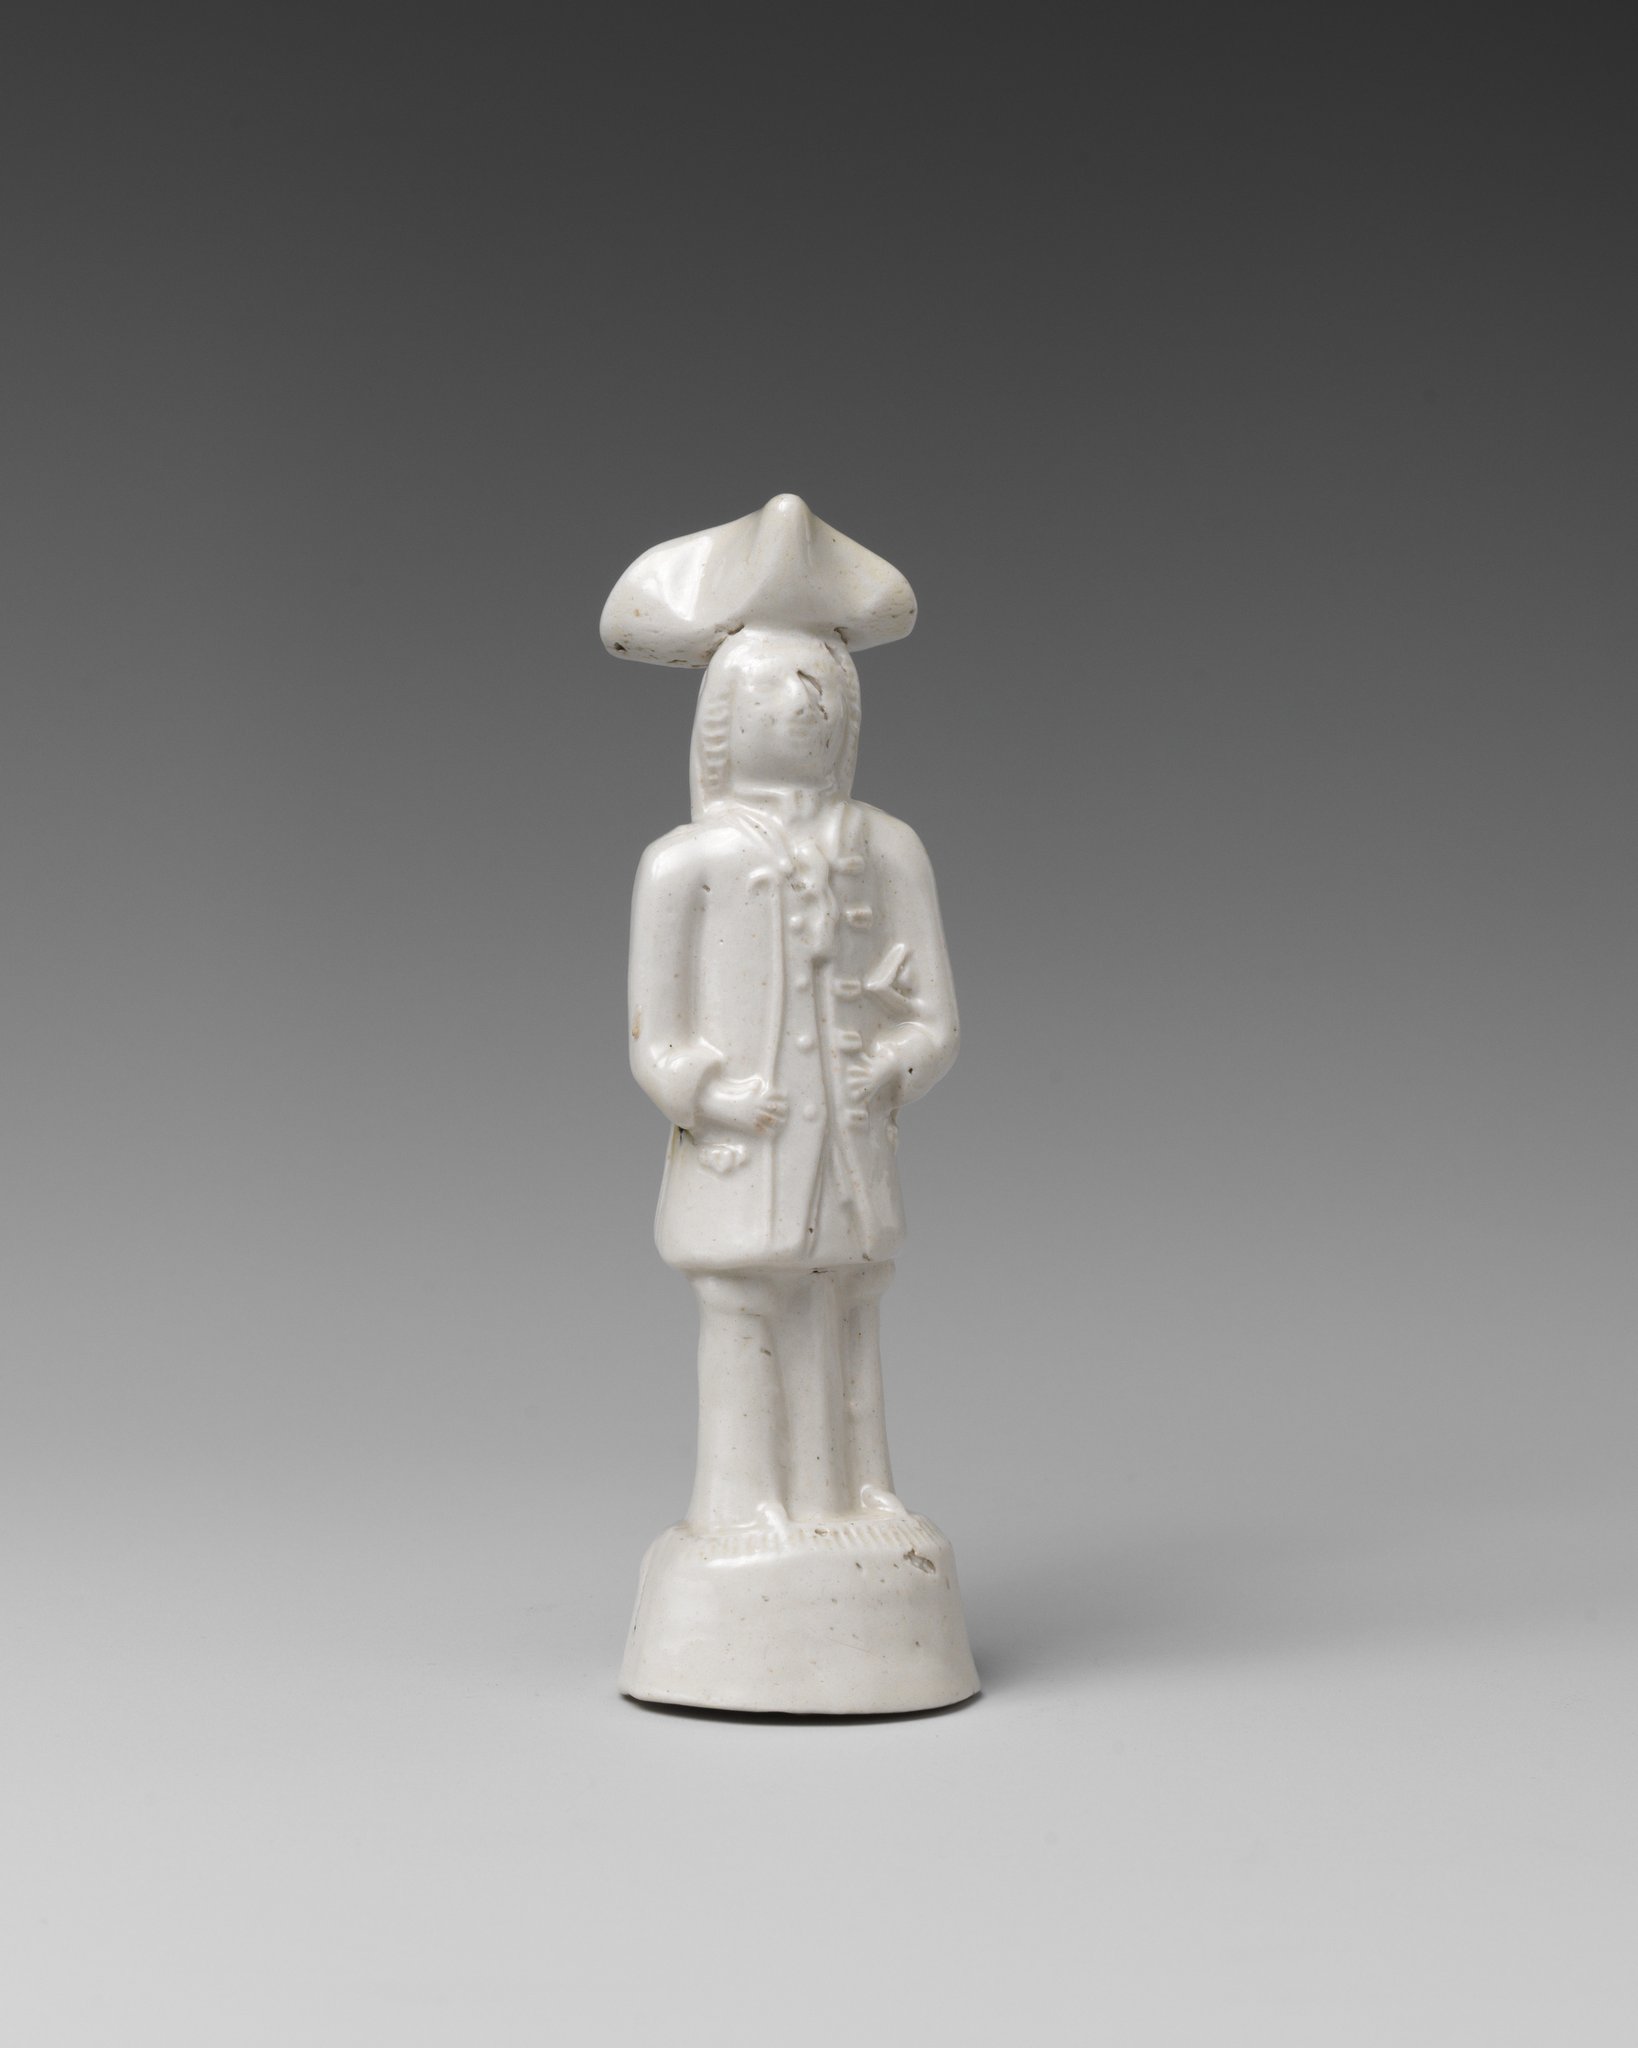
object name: figure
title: Figure of a man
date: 1750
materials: stoneware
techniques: salt glaze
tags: men